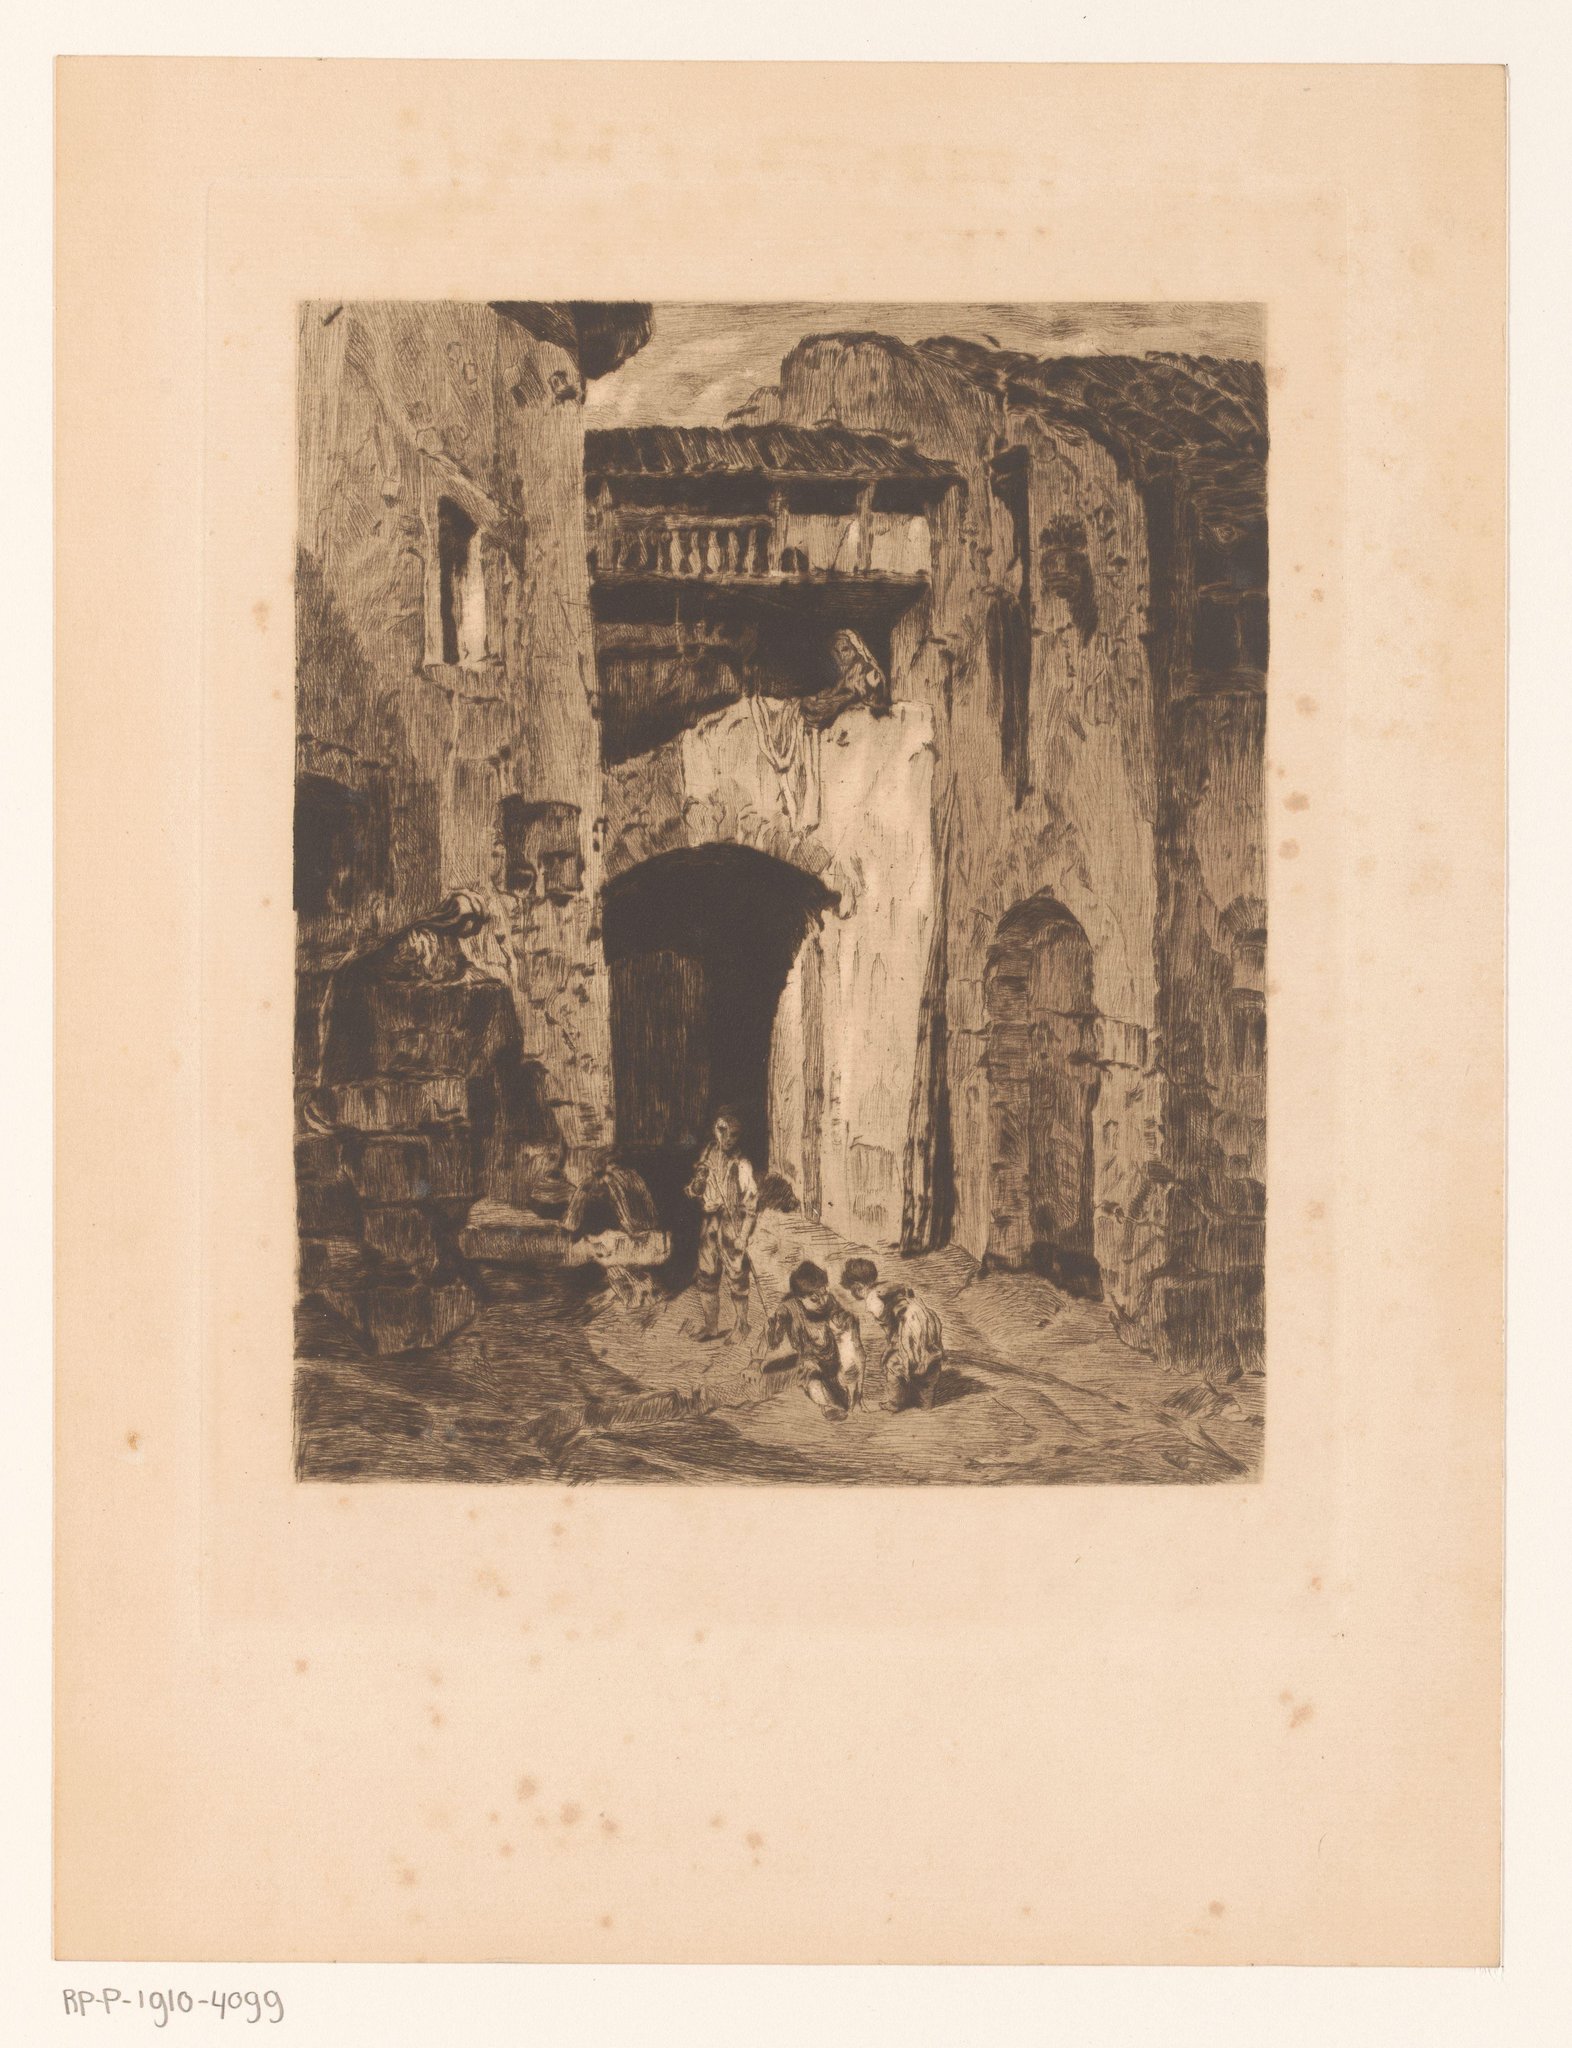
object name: print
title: Straatgezicht met spelende kinderen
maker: Anonymous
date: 1850-1910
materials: paper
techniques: drypoint, etching, intaglio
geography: belgium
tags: village street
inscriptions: collector's mark: Lugt 2228